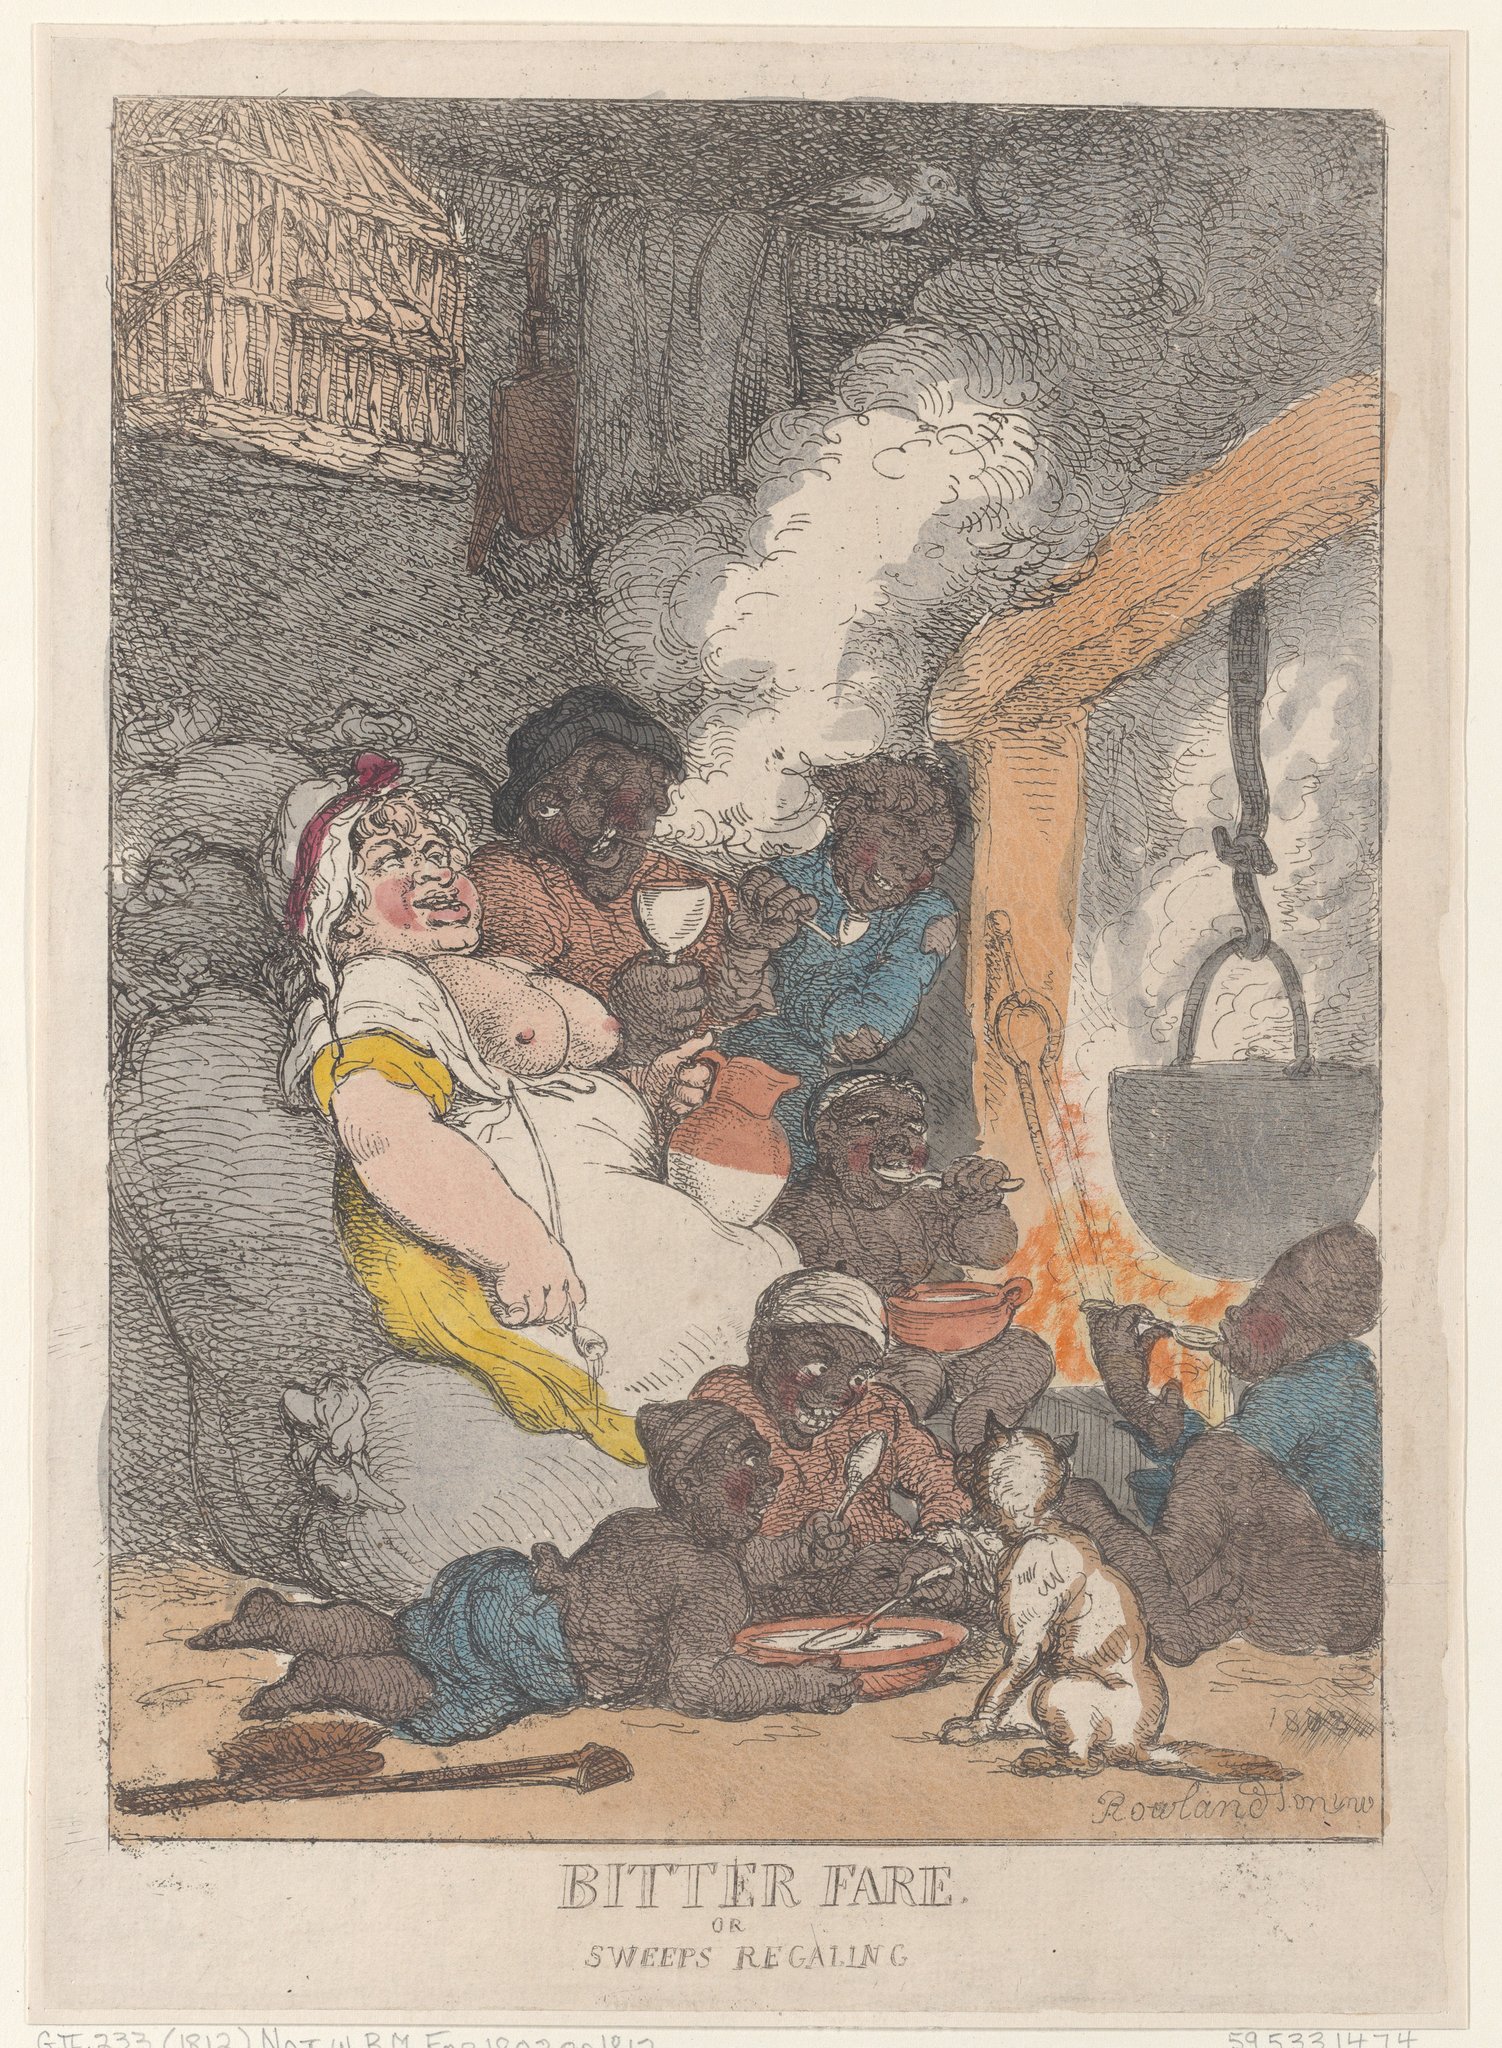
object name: print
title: Bitter Fare or Sweeps Regaling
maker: thomas rowlandson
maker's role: artist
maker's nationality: british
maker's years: 1757-1827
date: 1812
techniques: etching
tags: satire,children,men,women,smoking,eating